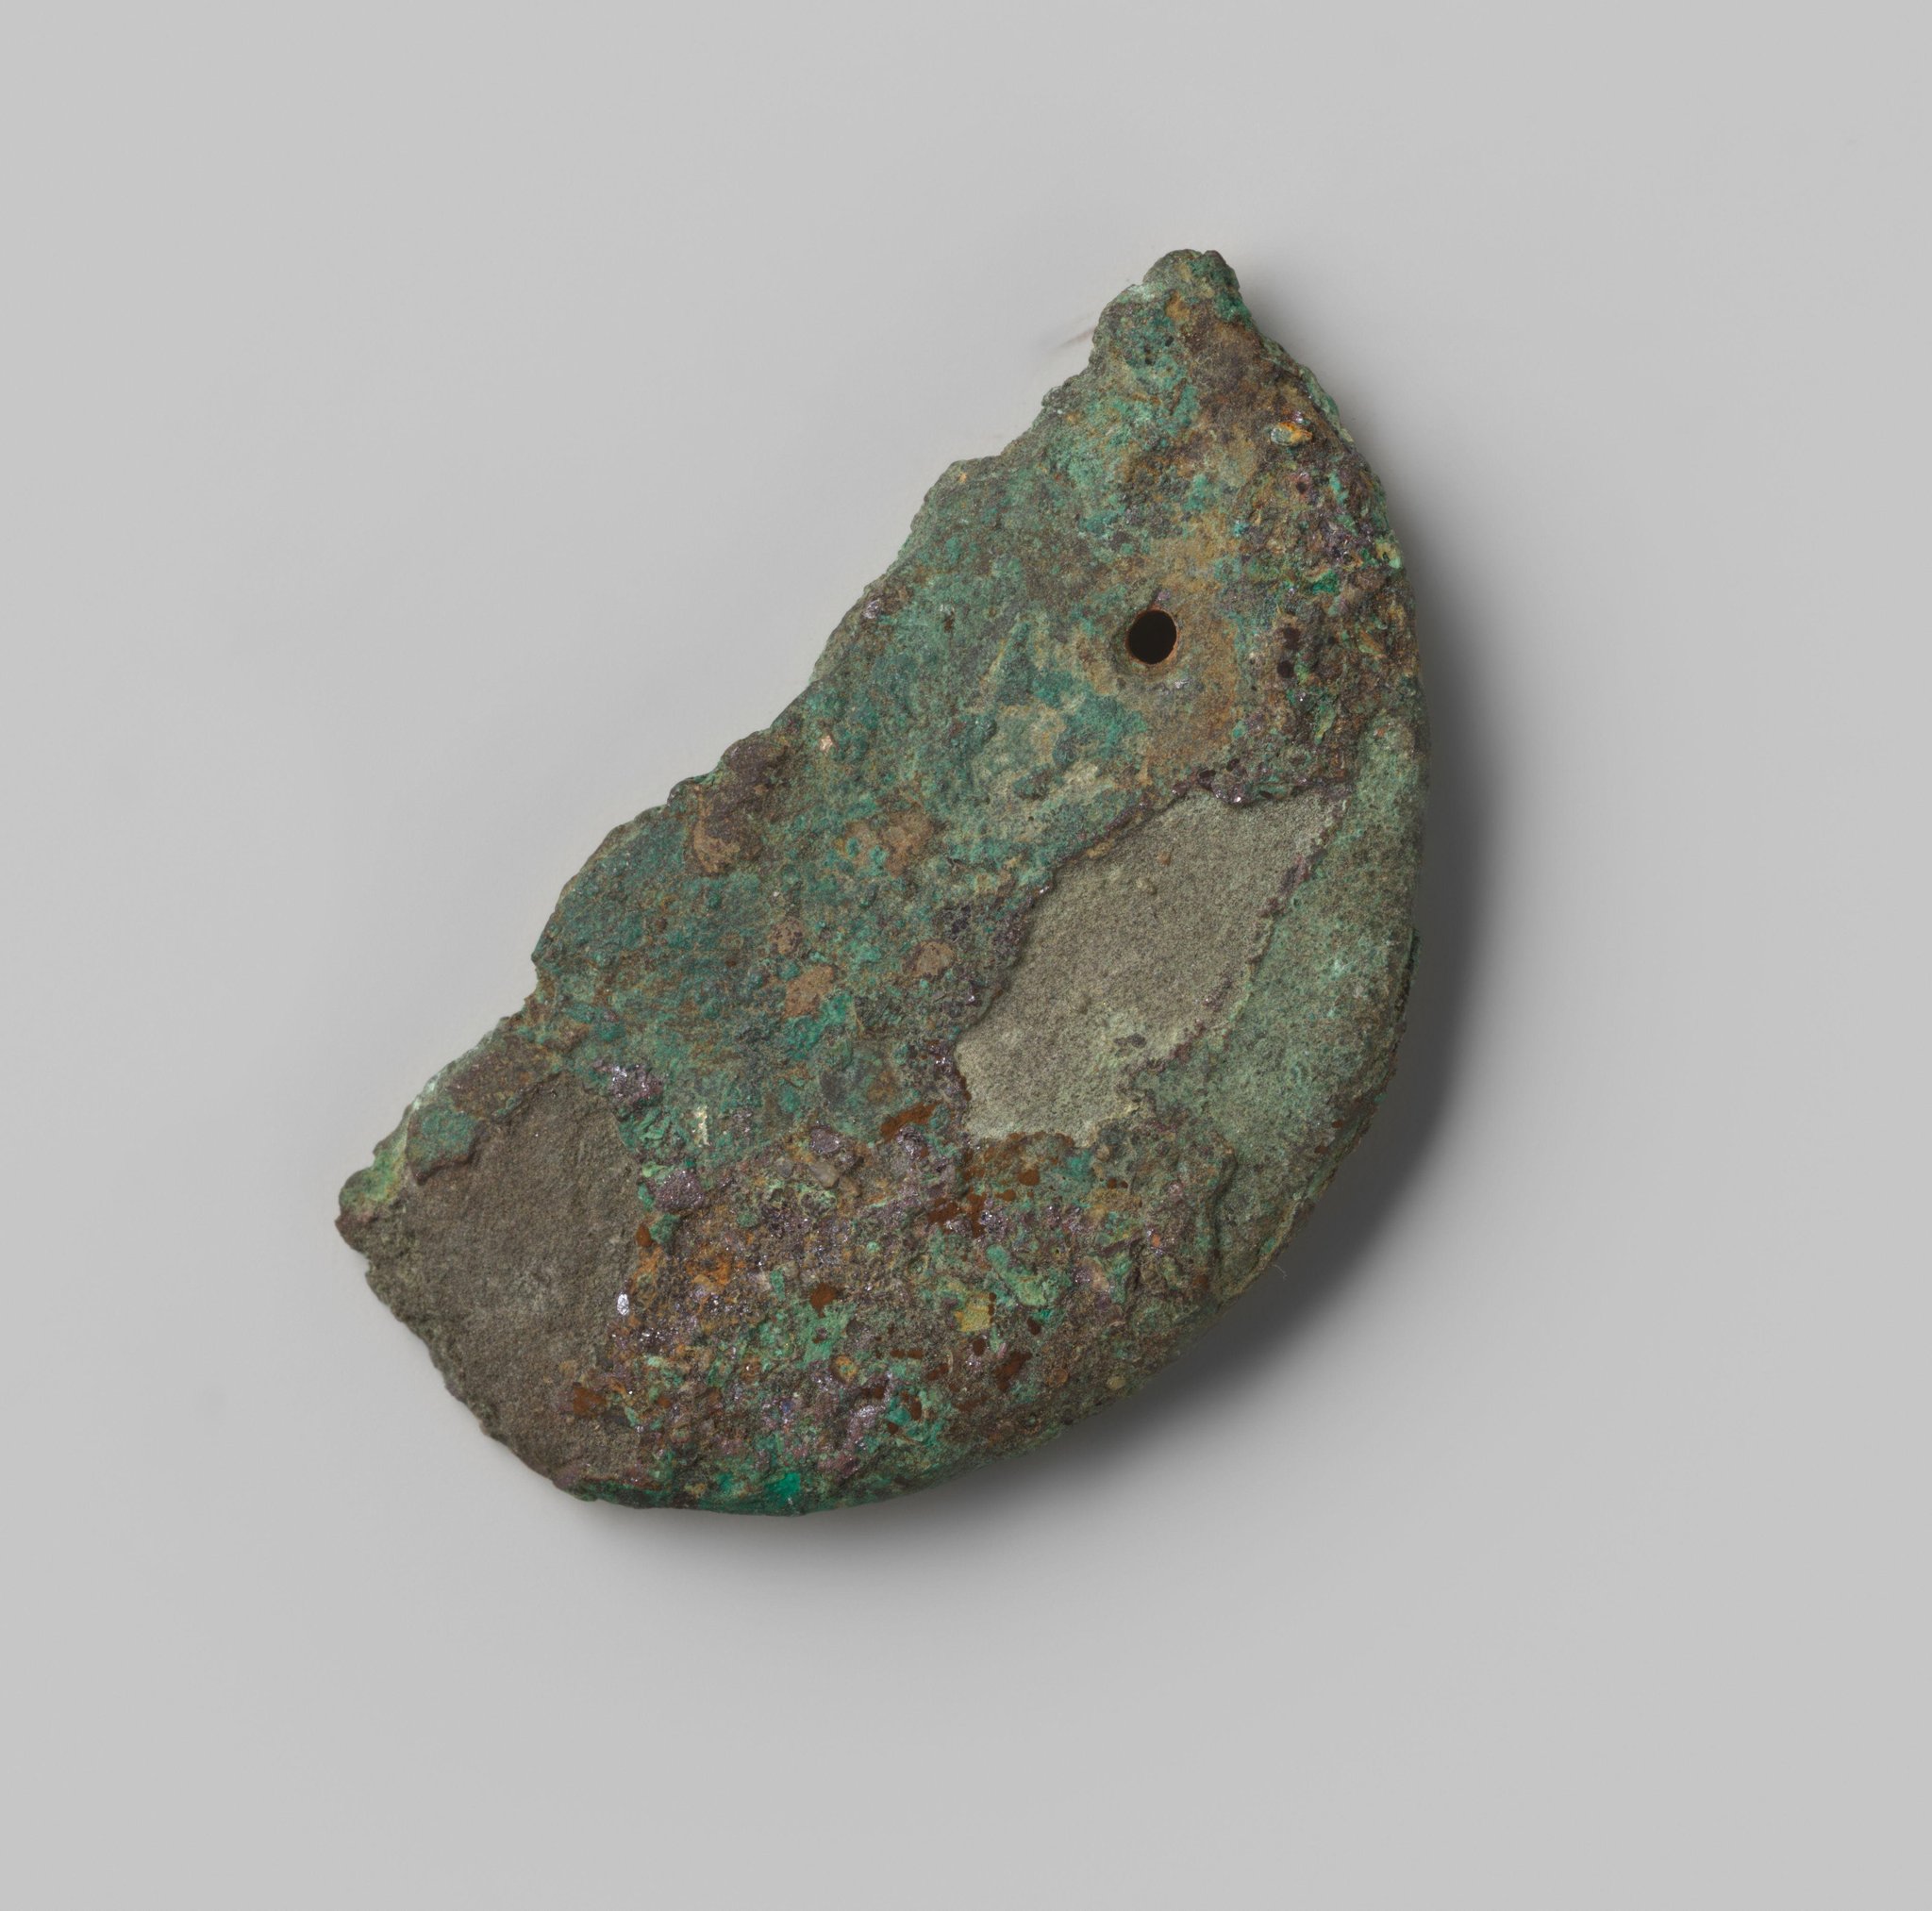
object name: lid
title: Fragment deksel van een sluitgewicht uit het wrak van de Oost-Indiëvaarder Hollandia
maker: Anonymous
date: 1700-1743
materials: copper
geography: netherlands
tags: verenigde oostindische compagnie, hollandia (schip), annet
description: Weight, cupweight, lid; fragm, id. NG 1980-27H33, eroded.